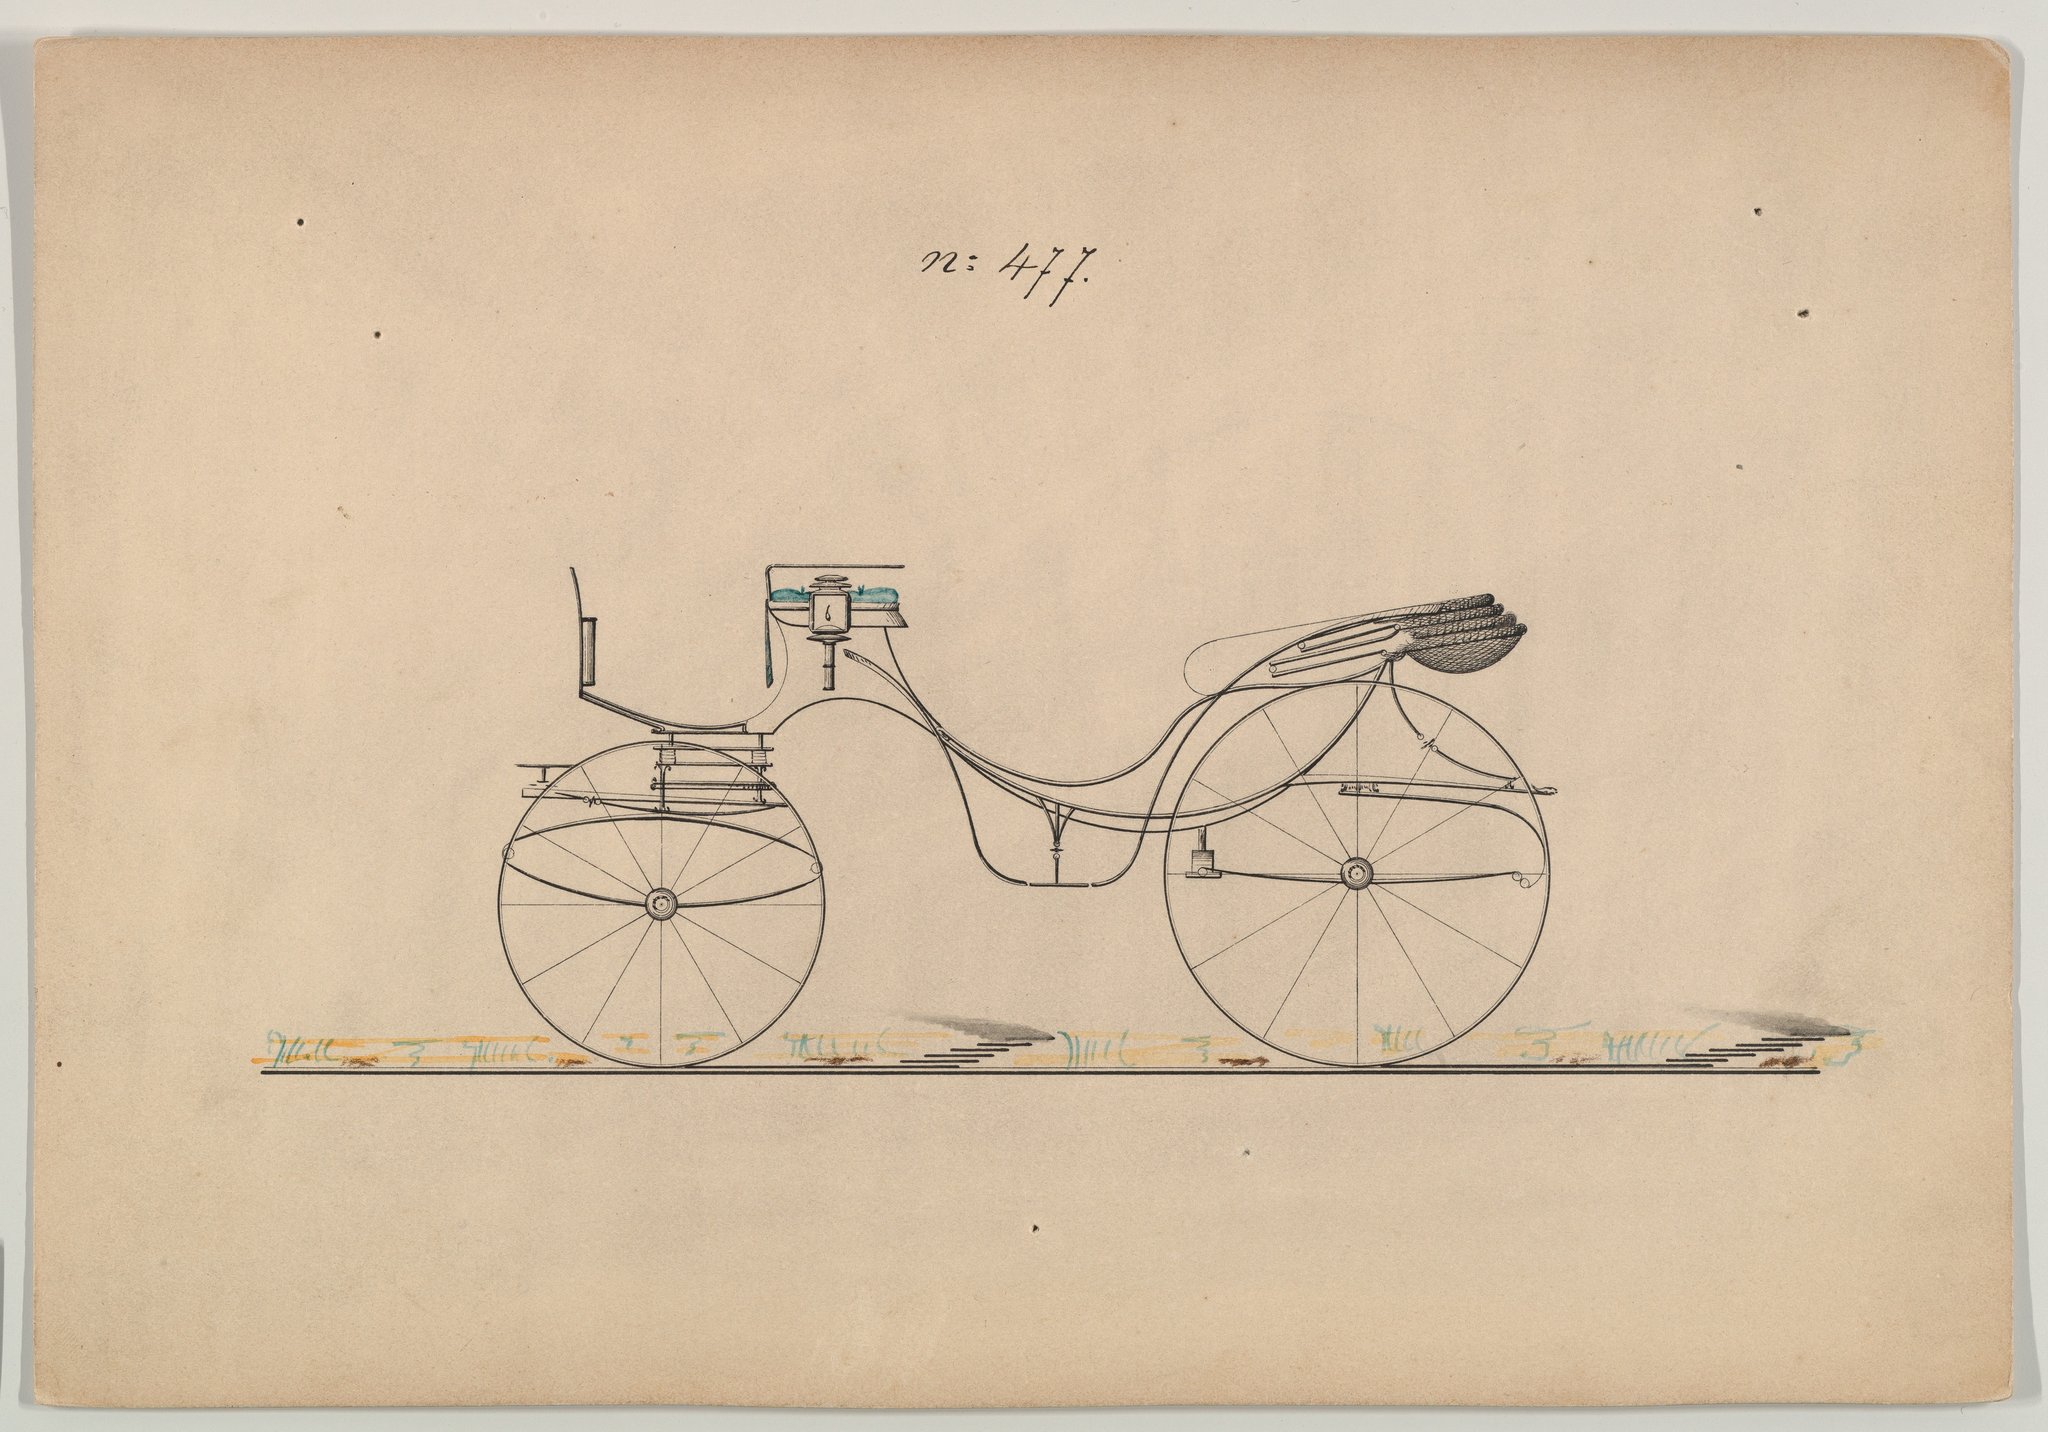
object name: drawing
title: Cabriolet #477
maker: brewster & co.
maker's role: manufacturer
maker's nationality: american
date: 1860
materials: gouache, ink, watercolor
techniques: pen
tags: carriages